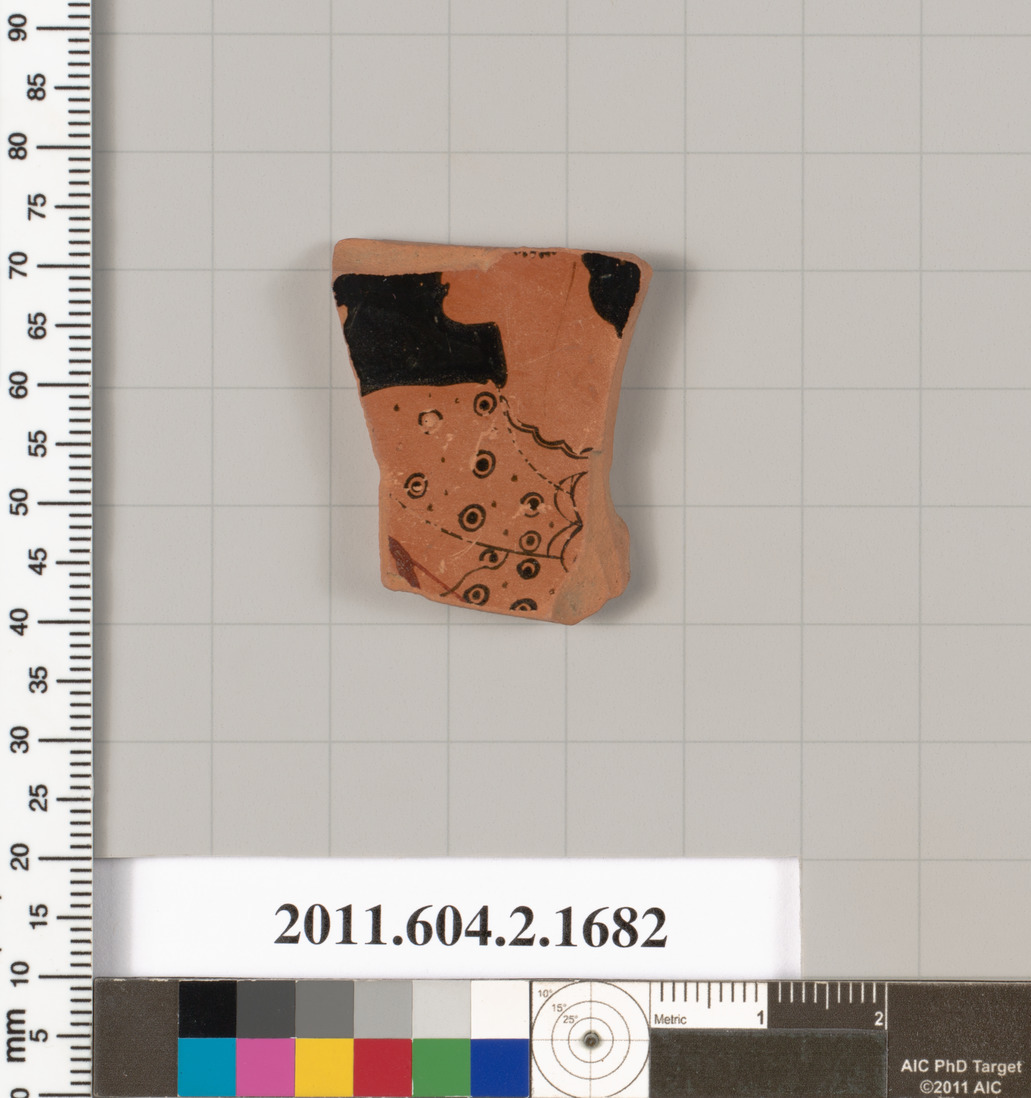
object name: skyphos fragment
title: Terracotta fragment of a skyphos (deep drinking cup)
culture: greek, attic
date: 490-480 BCE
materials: terracotta